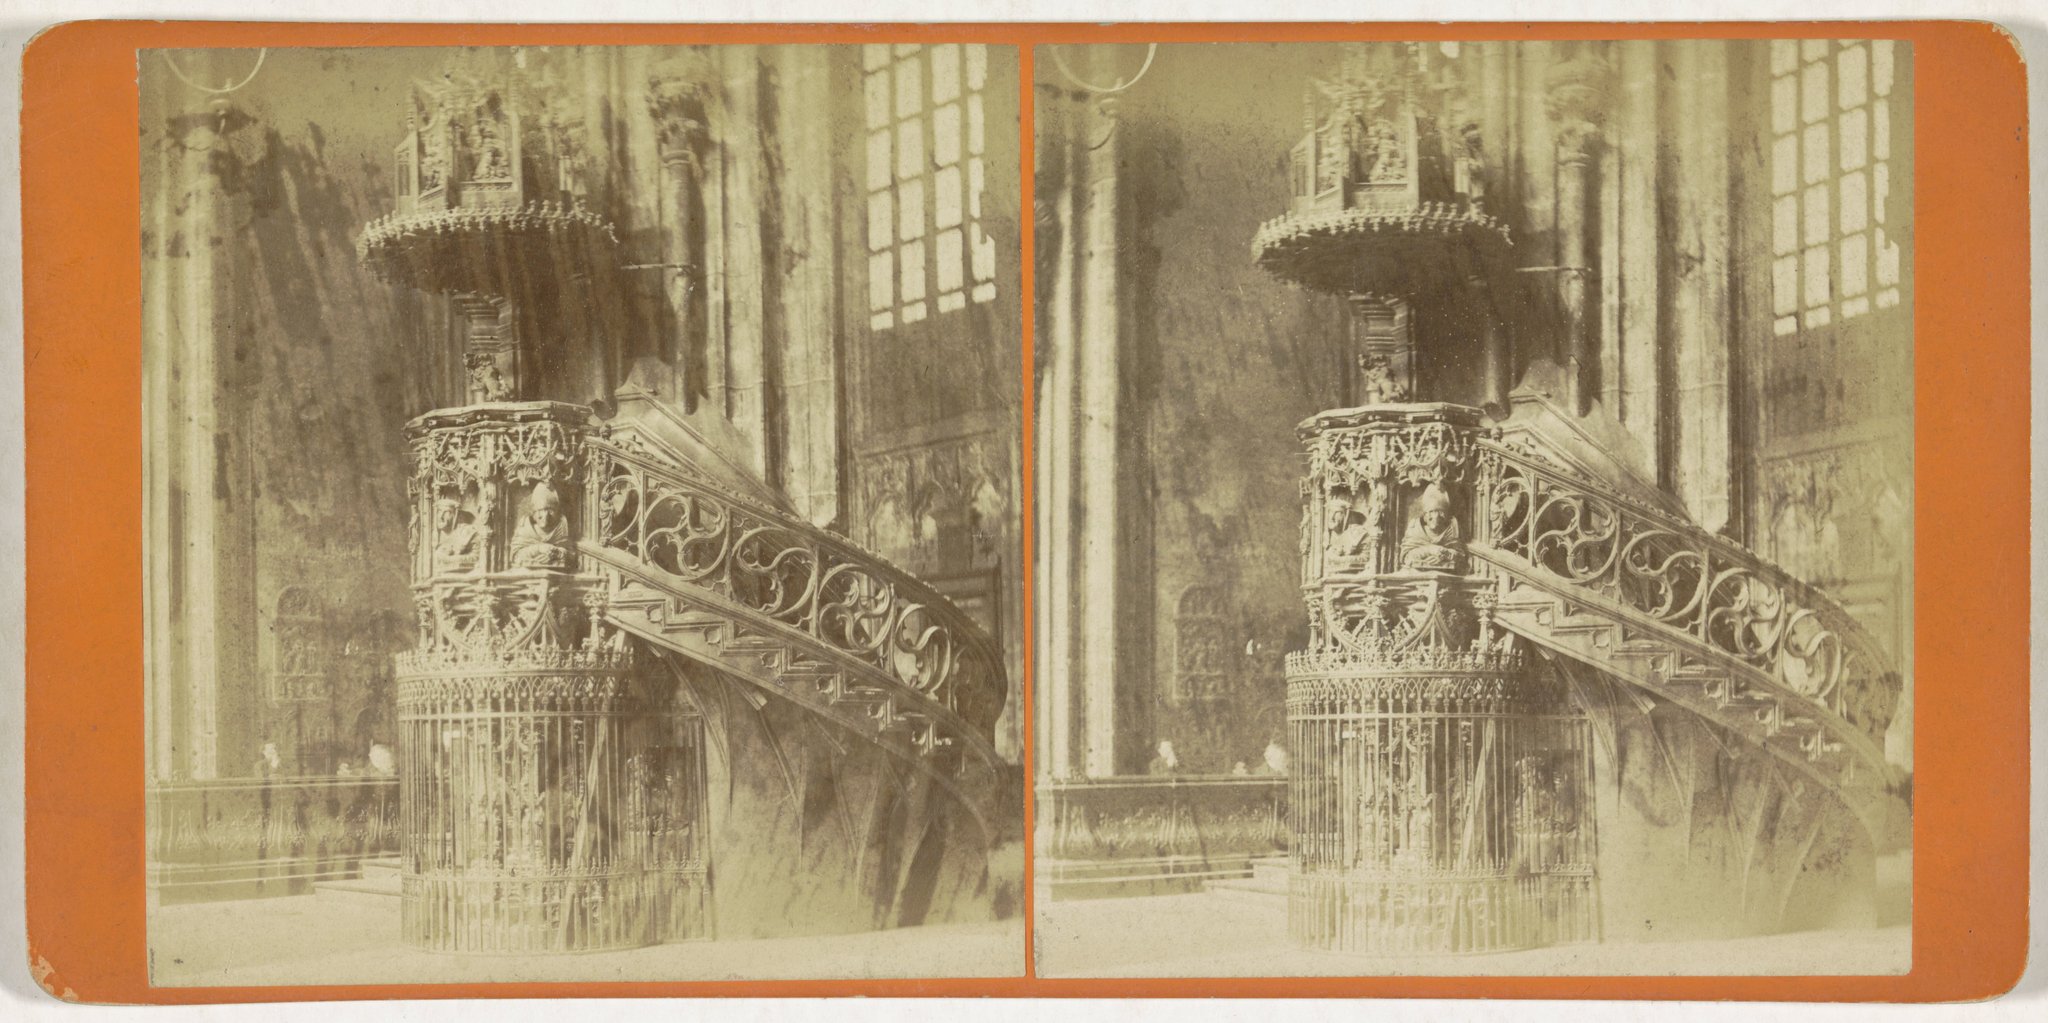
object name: stereograph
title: Preekstoel in de Stephansdom, Wenen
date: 1870-1877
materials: cardboard, paper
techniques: albumen print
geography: vienna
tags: interior of church, pulpit, ambo, chancel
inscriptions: address: ‘vom 12. Nov. 1870 ab Kohlmarkt 18 (früher Graben Nr. 9).’, inscription: ‘Stefan's Kirche’